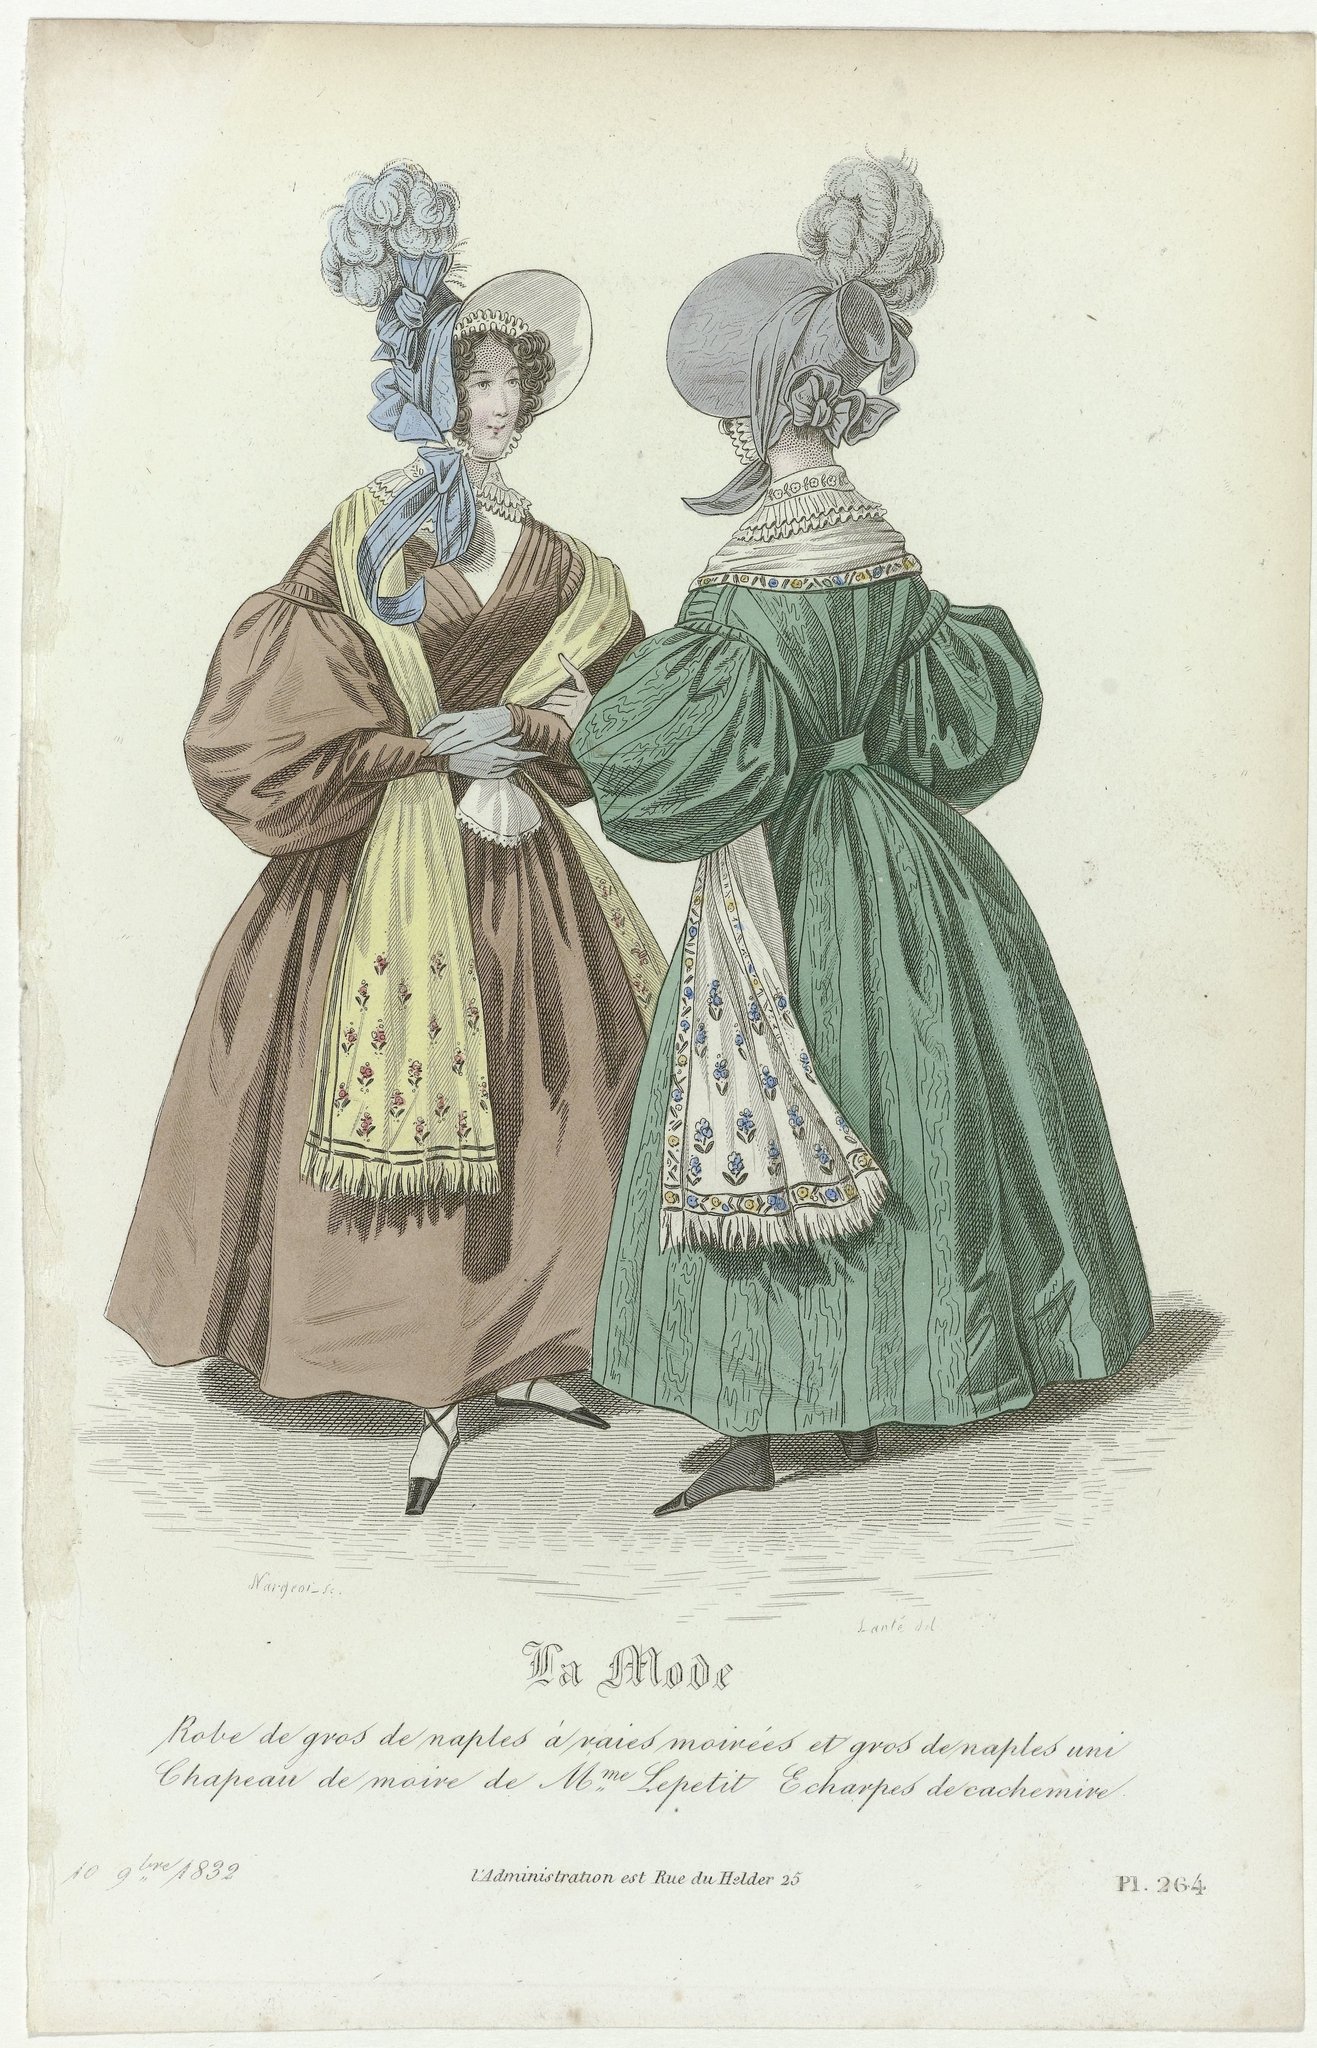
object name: fashion print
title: La Mode, 10 novembre 1832, Pl. 264 : Robe de gros de naples (...)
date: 1832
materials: paper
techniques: hand coloring, engraving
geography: paris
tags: clothing for the upper part of the body (shawl) (+ women's clothes), boots (+ women's clothes), fashion plates, head-gear: hat (+ women's clothes), shoes, sandals (+ women's clothes), gloves, mittens, etc. (+ women's clothes), dress, gown (+ women's clothes), neck-gear ~ clothing (+ women's clothes)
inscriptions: address: ‘L'Administration est Rue du Helder 25.’, title: ‘La Mode.’, caption: ‘Robe de gros de naples à raies moirées et gros de naples uni Chapeau de moire de M"me Lepetit Echarpes de cachemire’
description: Japonnen van 'gros de naples' gestreept met moiré en van effen 'gros de naples'. Hoed van moiré van Lepetit. Sjaals van kasjmier. Verdere accessoires: handschoenen, zakdoek, platte schoenen met gekruiste banden, laarzen. Prent uit het modetijdschrift La Mode (1829-1855).